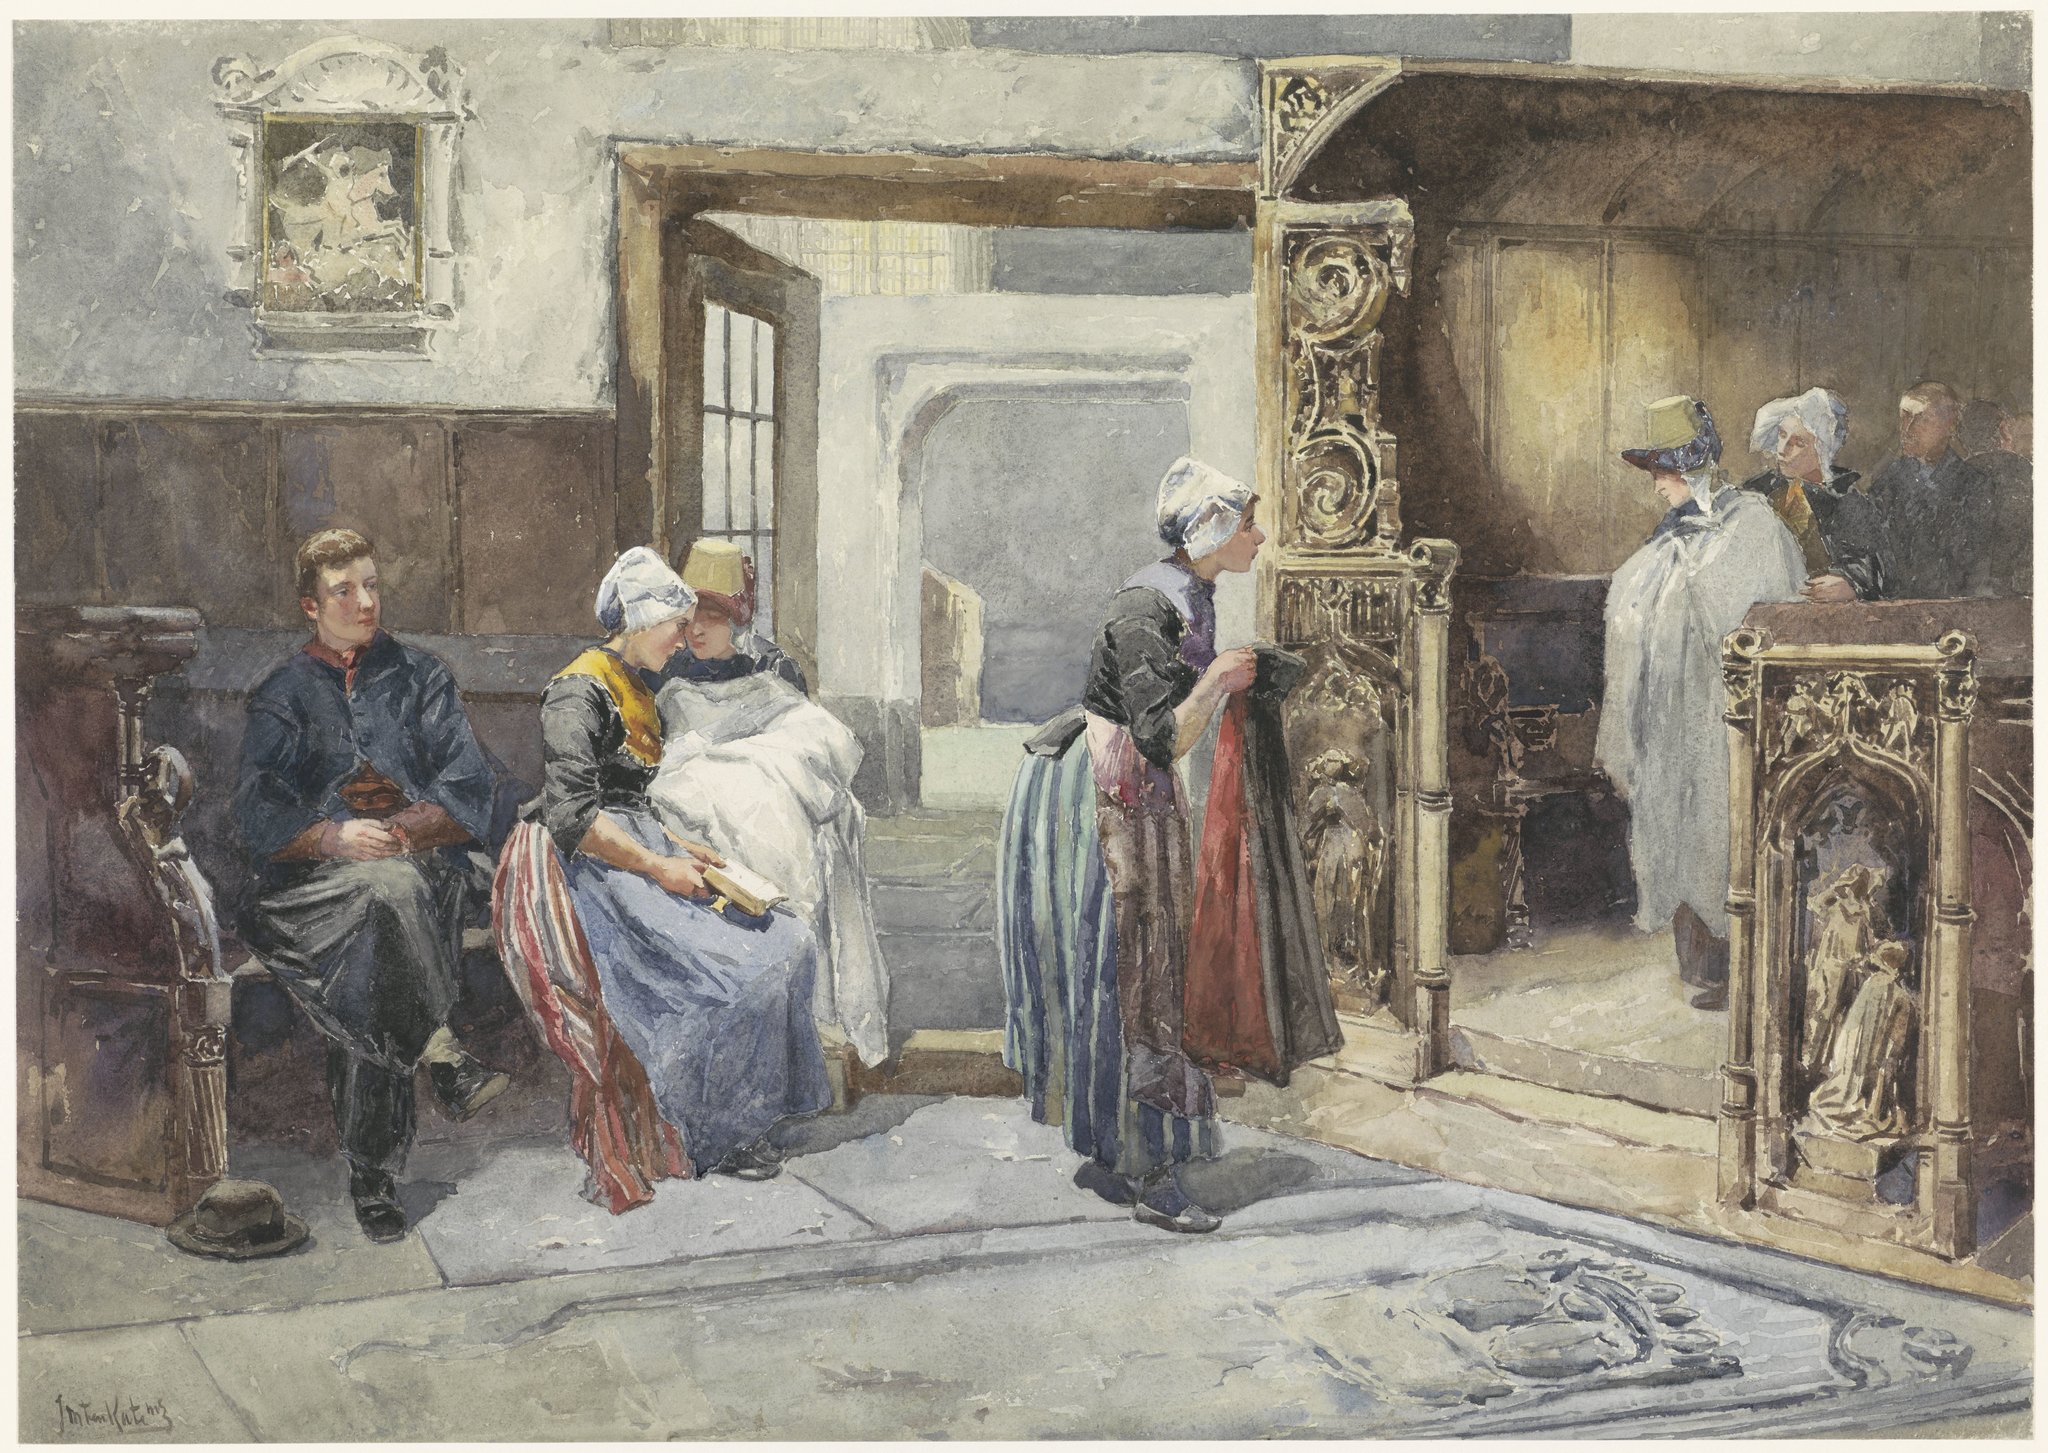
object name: watercolor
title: Na de Doop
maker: mari ten kate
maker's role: draughtsman, painter, print maker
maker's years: 1831-1910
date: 1841-1892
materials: paper, watercolor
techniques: brush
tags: baptism, christening ceremony ~ the first of the seven sacraments, interior of church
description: Kerkinterieur met links en rechts diverse mensen en in het midden een meisje met een cape in de hand.